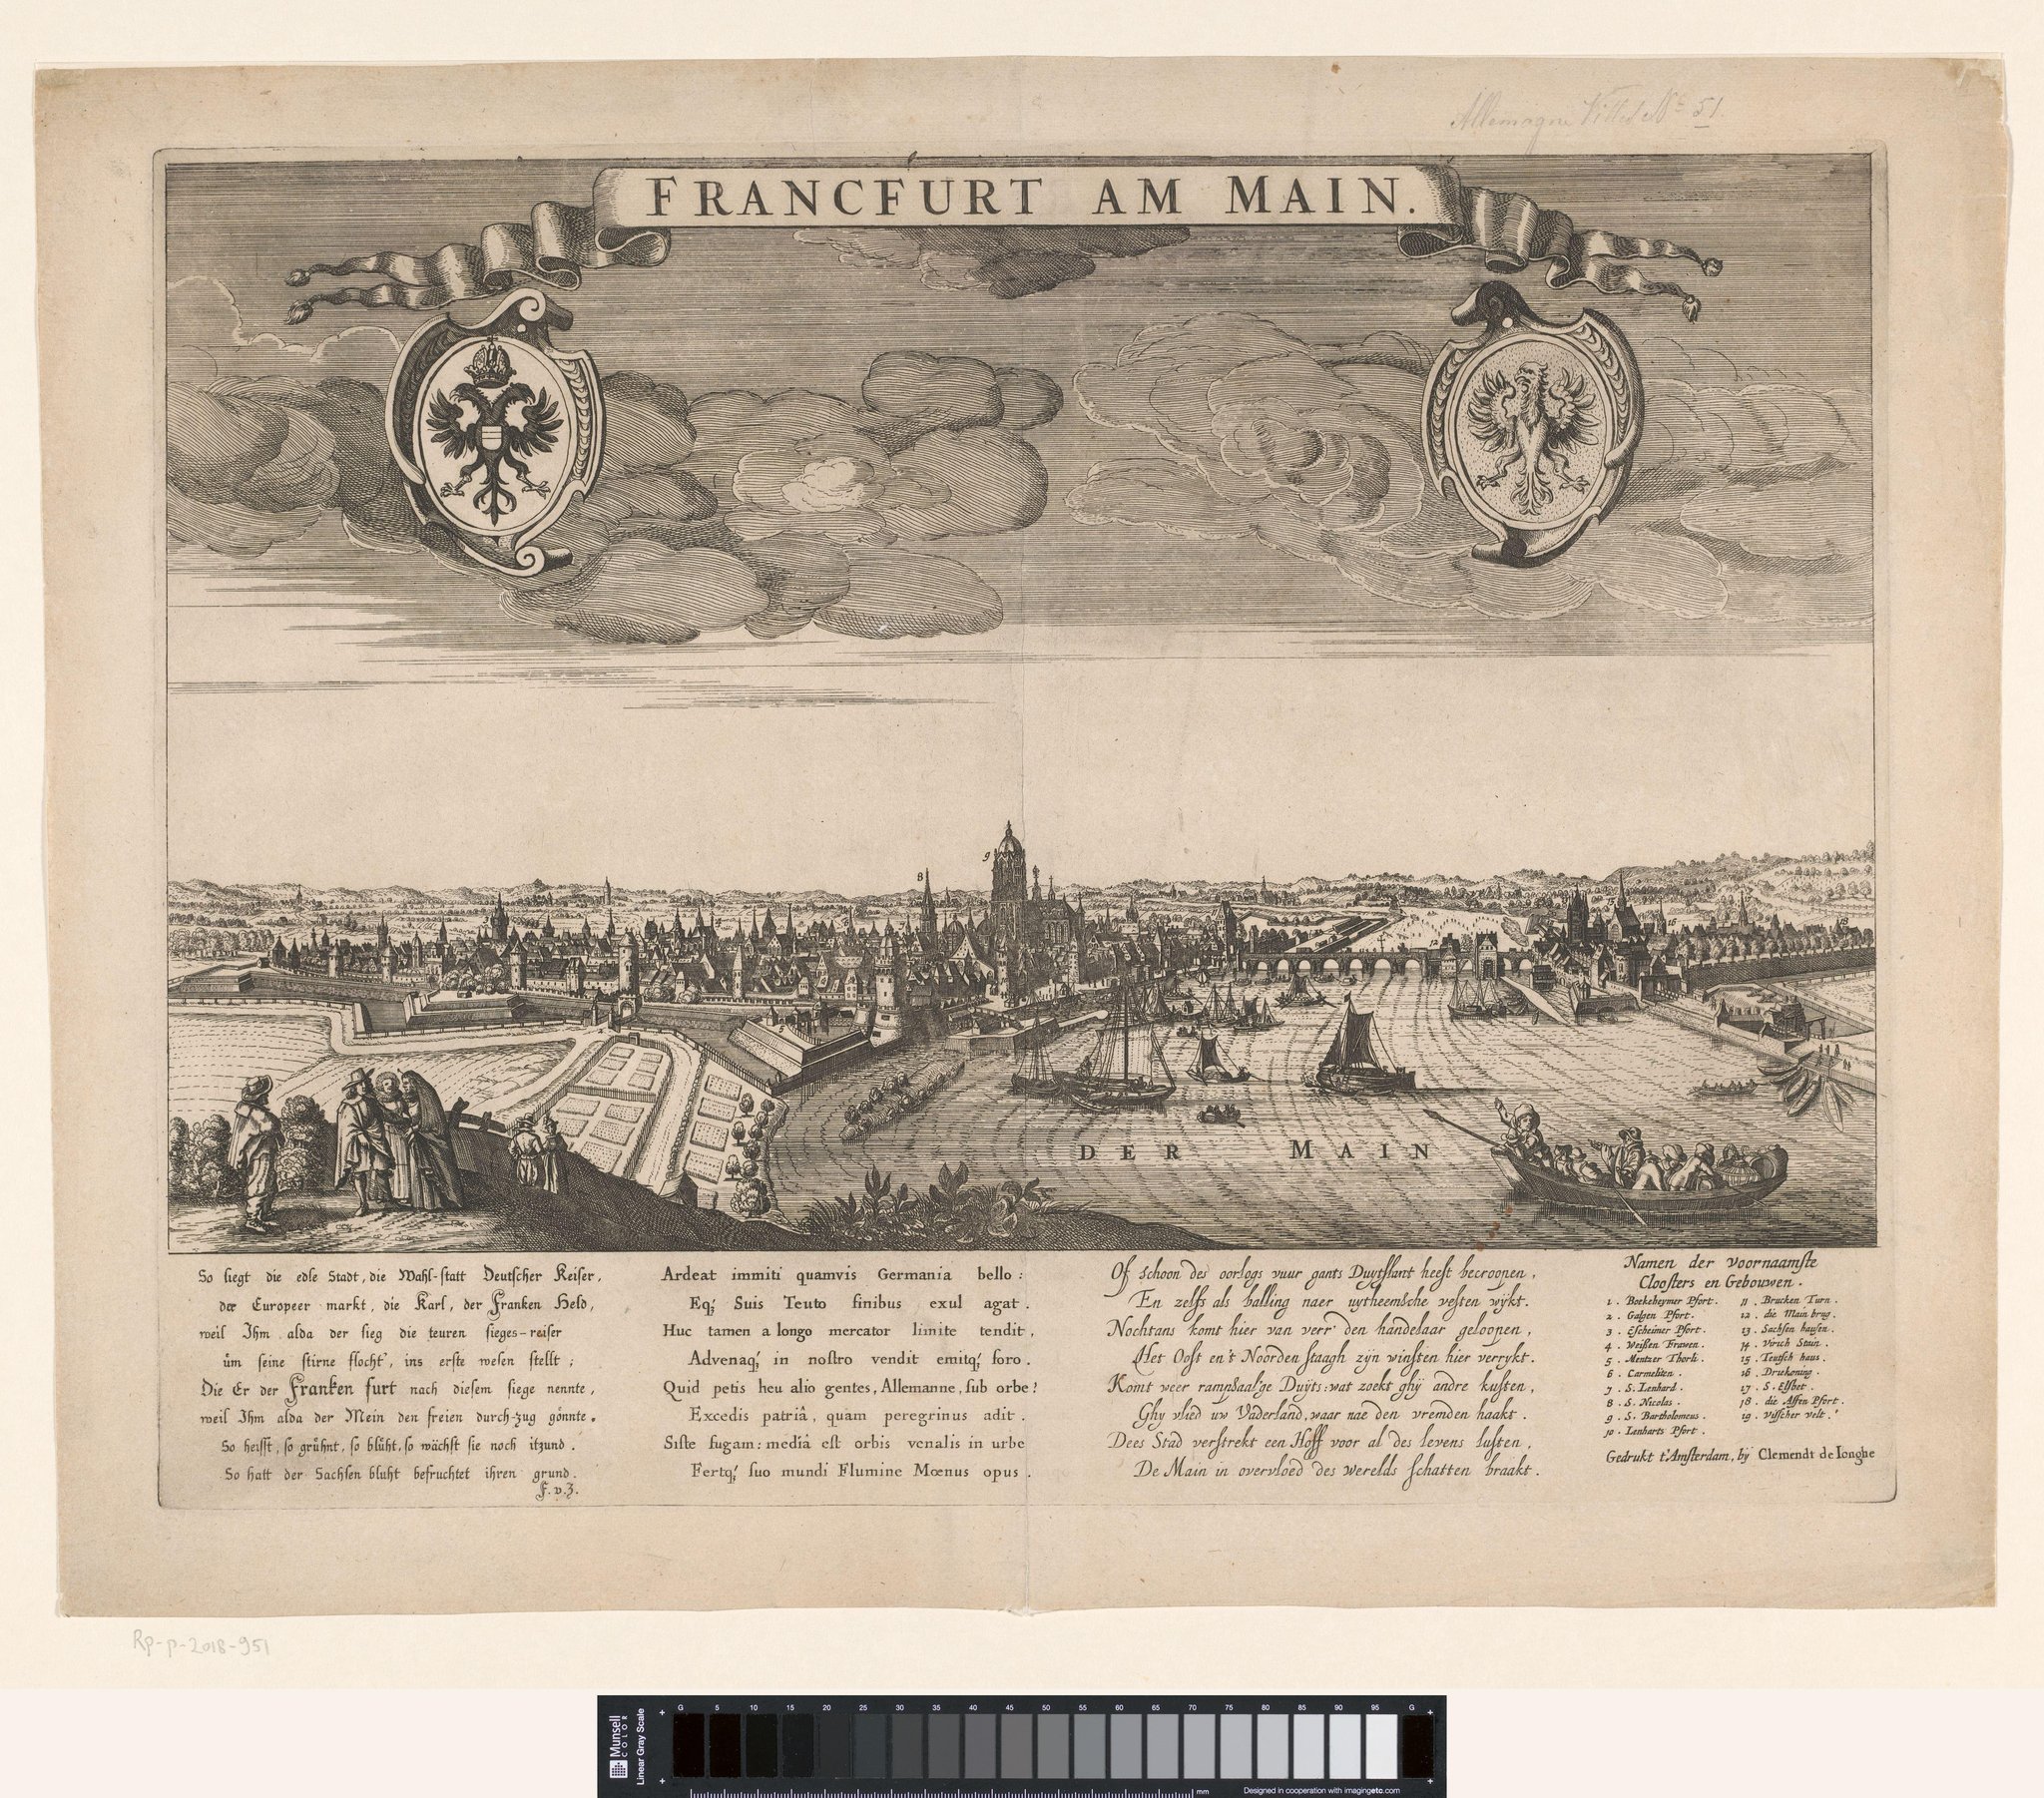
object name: print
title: Gezicht op Frankfurt am Main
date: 1643-1679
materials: paper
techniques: engraving, etching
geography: amsterdam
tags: coat of arms (as symbol of the state, etc.) (+ city; municipal), coat of arms (as symbol of the state, etc.) (+ province; provincial), prospect of city, town panorama, silhouette of city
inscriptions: collector's mark: Lugt 2228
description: Gezicht op Frankfurt am Main. Onder een tekst in het Duits, Latijn en Nederlands.